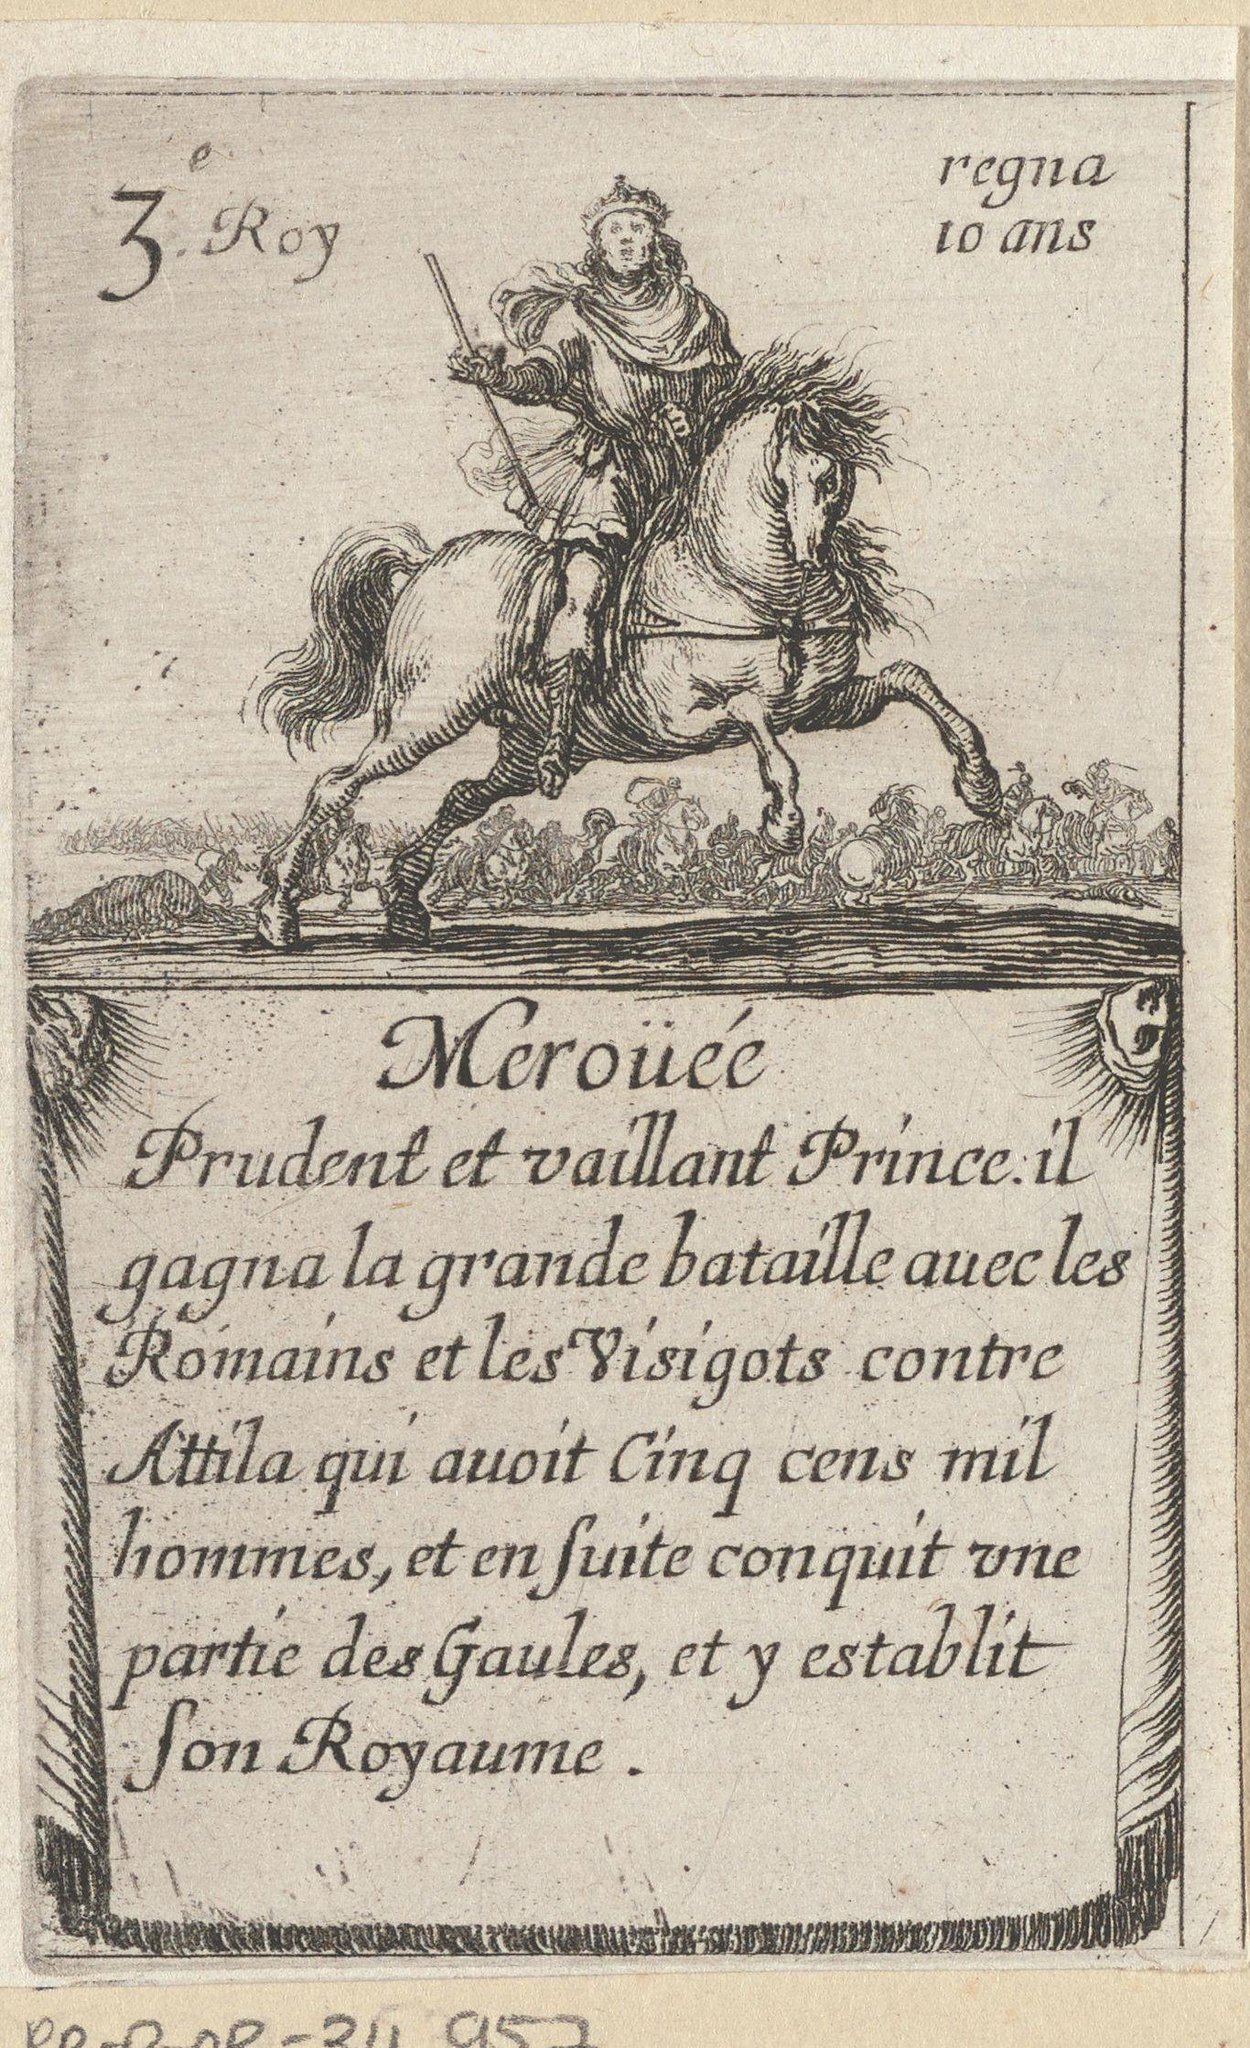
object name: print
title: Meroüée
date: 1620-1664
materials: paper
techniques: etching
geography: paris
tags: ruler, sovereign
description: Deze prent maakt deel uit van een kaartspel met 39 kaarten met voorstellingen van Franse koningen. De serie is uitgedacht door Jean Desmarests de Saint-Sorlin in opdracht van Kardinaal Mazarin. Het kaartspel werd gemaakt voor de jonge Lodewijk XIV, samen met het Jeu des Fables, Jeu des Reynes Renommées en Jeu de la géographie.